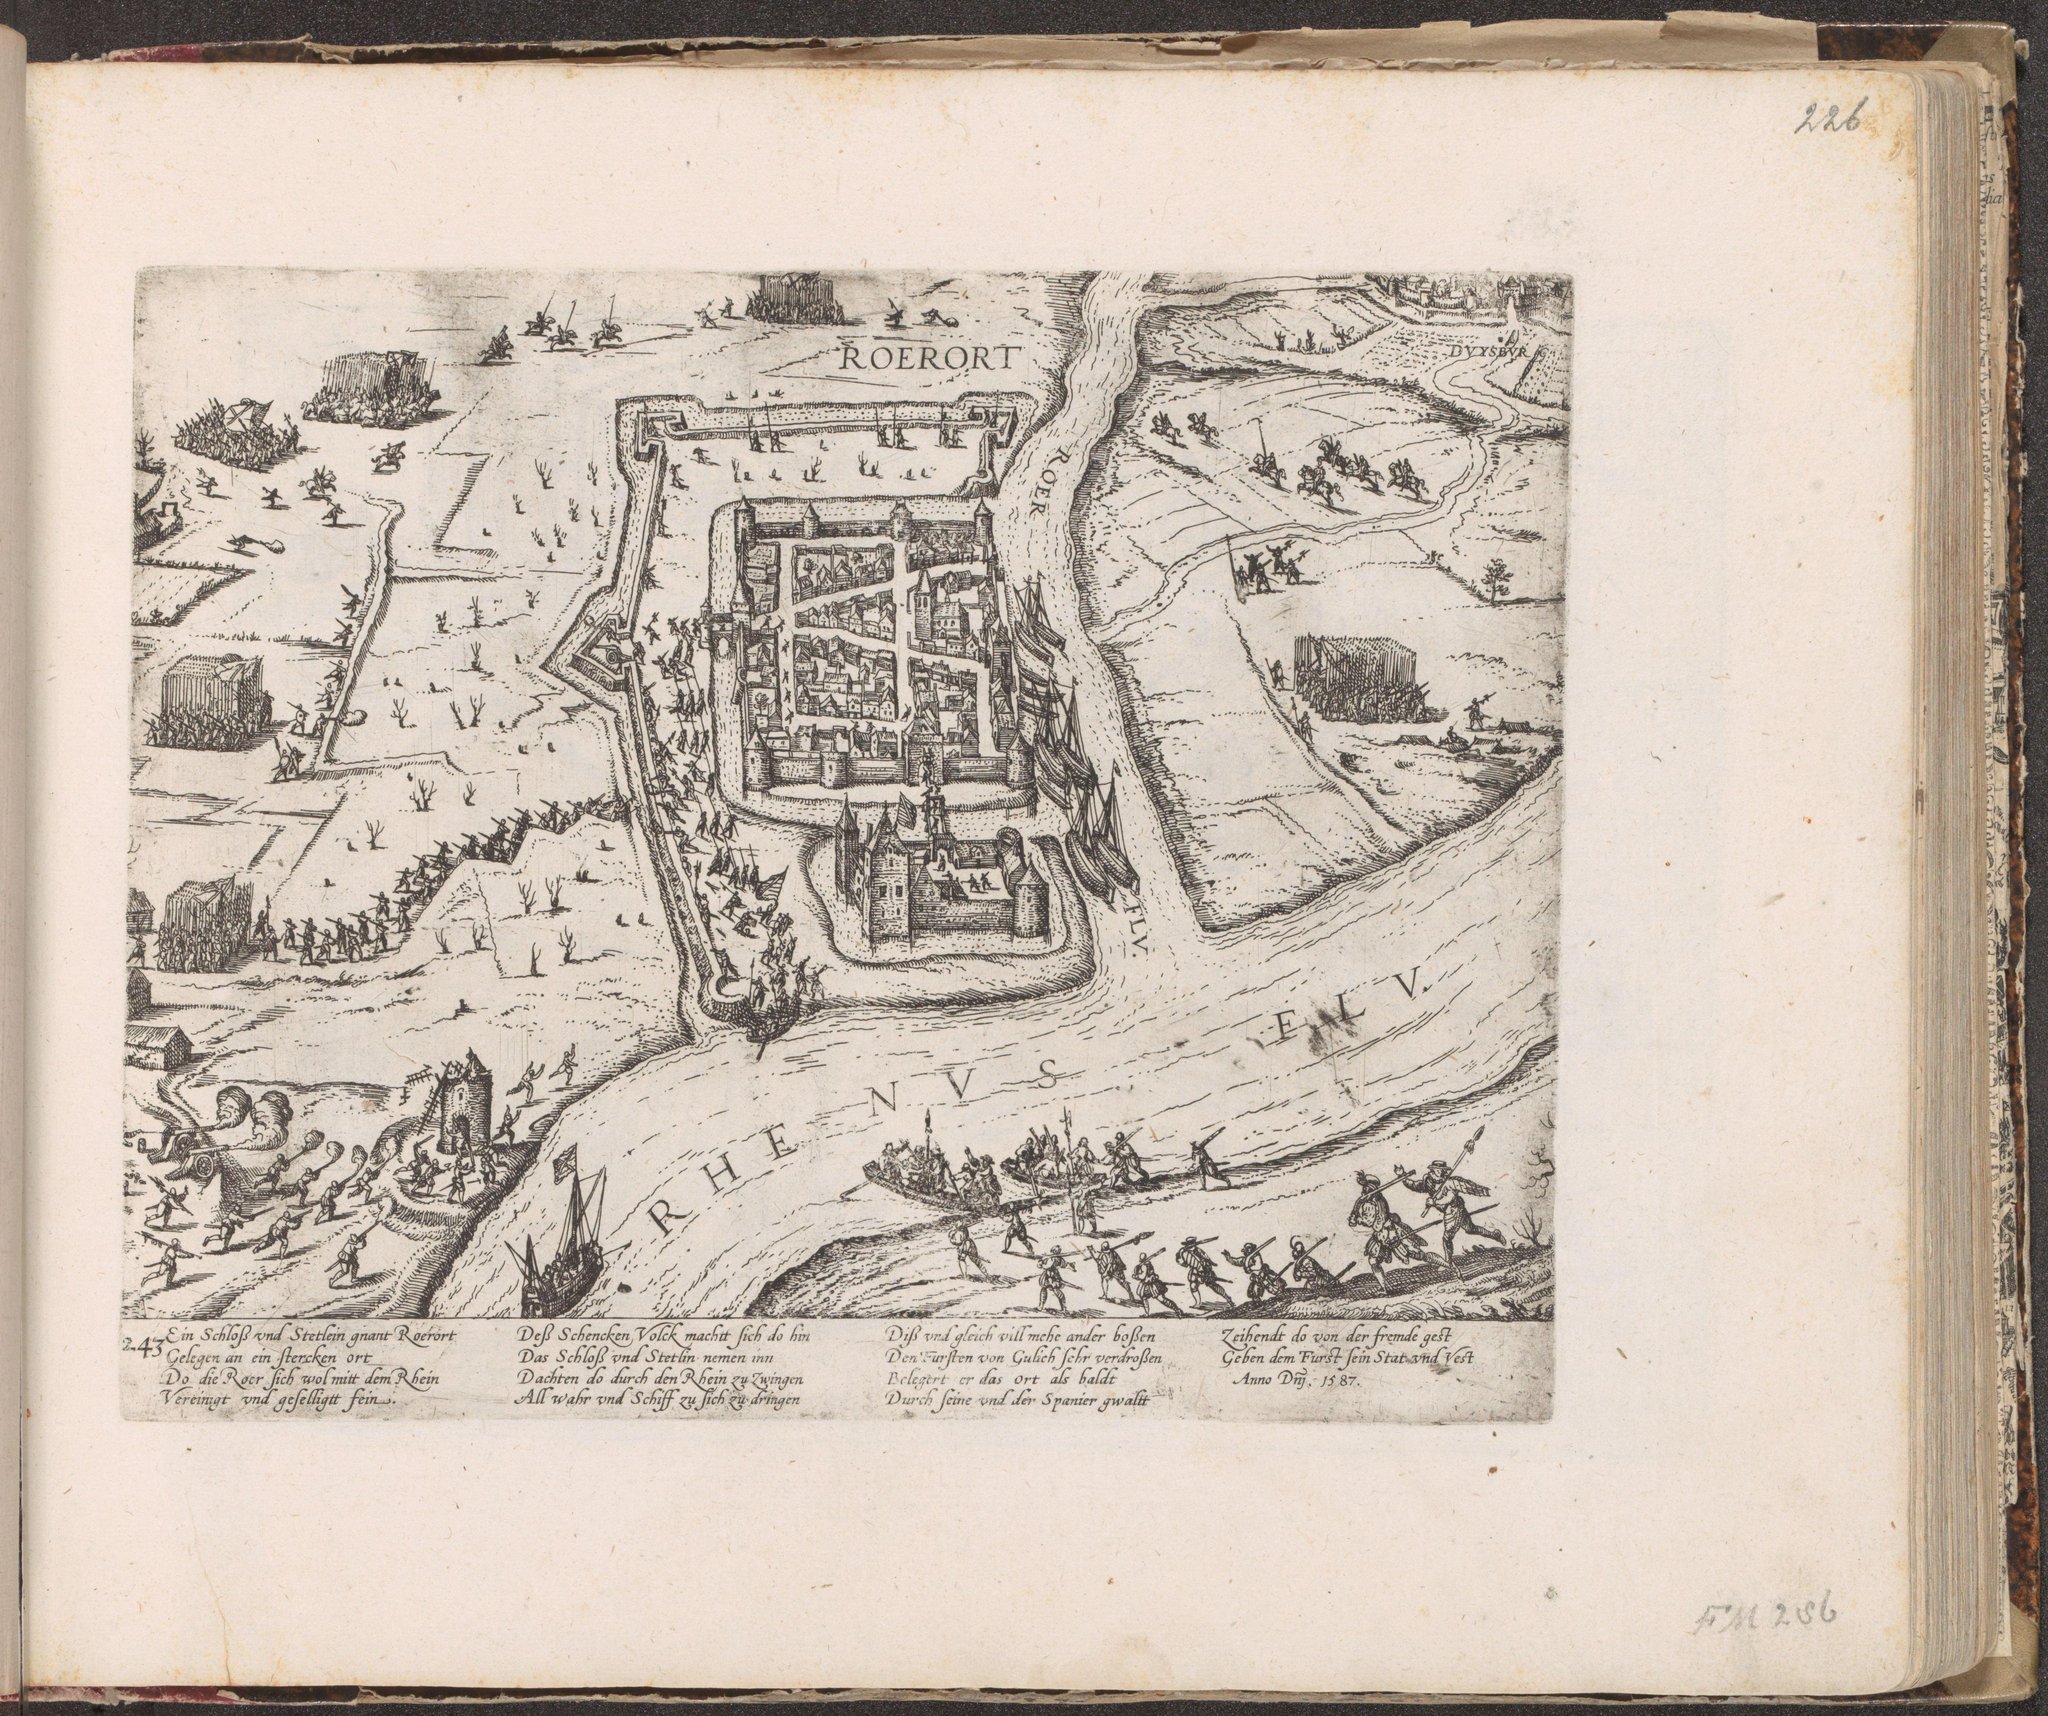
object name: history print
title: Inname van Ruhrort, 1587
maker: frans hogenberg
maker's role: print maker, publisher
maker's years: 1538-1590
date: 1587-1591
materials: paper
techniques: etching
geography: cologne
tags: nijmegen, capture of city (after the siege)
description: Ruhrort veroverd op de troepen van Schenck, januari 1587. Episode uit de Keulse Oorlog. Met onderschrift van 14 regels in het Duits. Linksonder genummerd: 243. De prent maakt deel uit van een album.